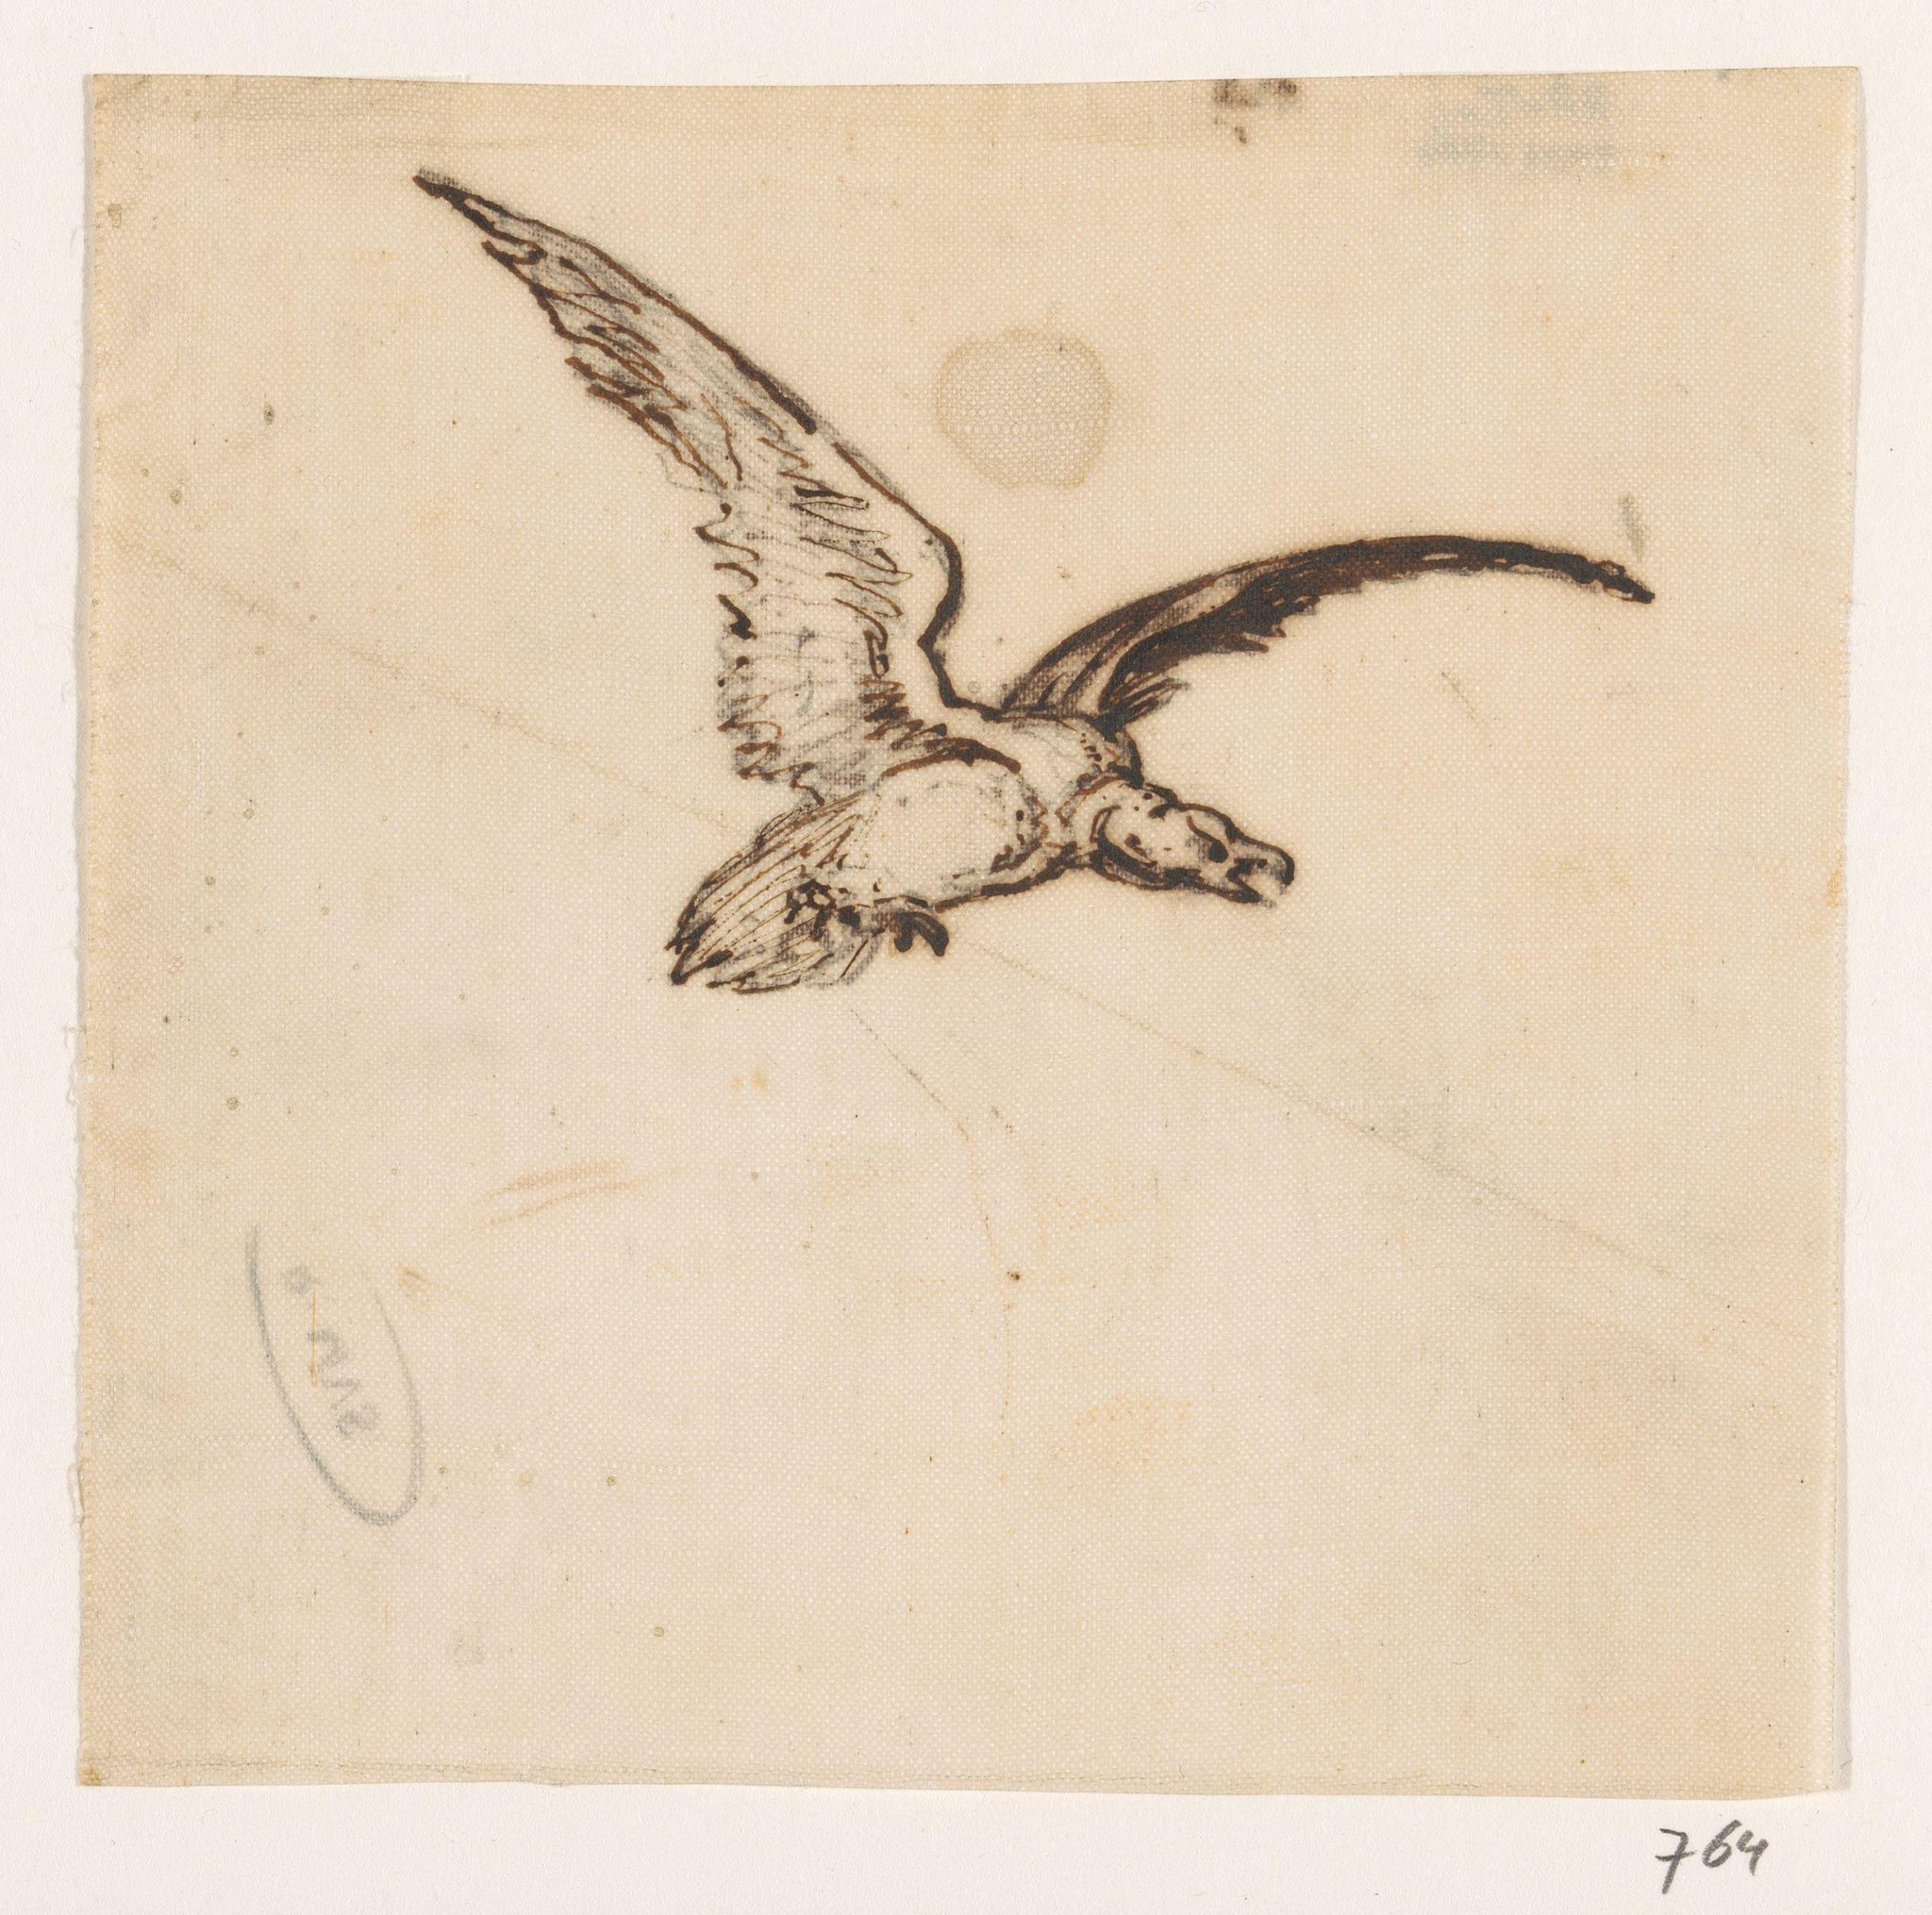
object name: drawing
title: Roofvogel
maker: johannes tavenraat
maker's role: draughtsman, painter, print maker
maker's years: 1809-1881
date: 1840-1880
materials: ink, paper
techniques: pen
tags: predatory birds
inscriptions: collector's mark: Lugt 2228